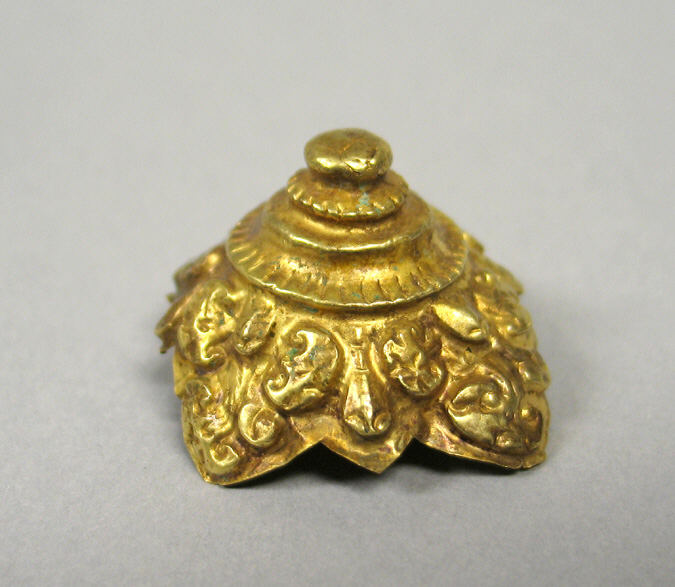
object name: repousse cover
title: Repousse Cover, Quatrefoil form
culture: indonesian, central java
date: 701-1200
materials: gold